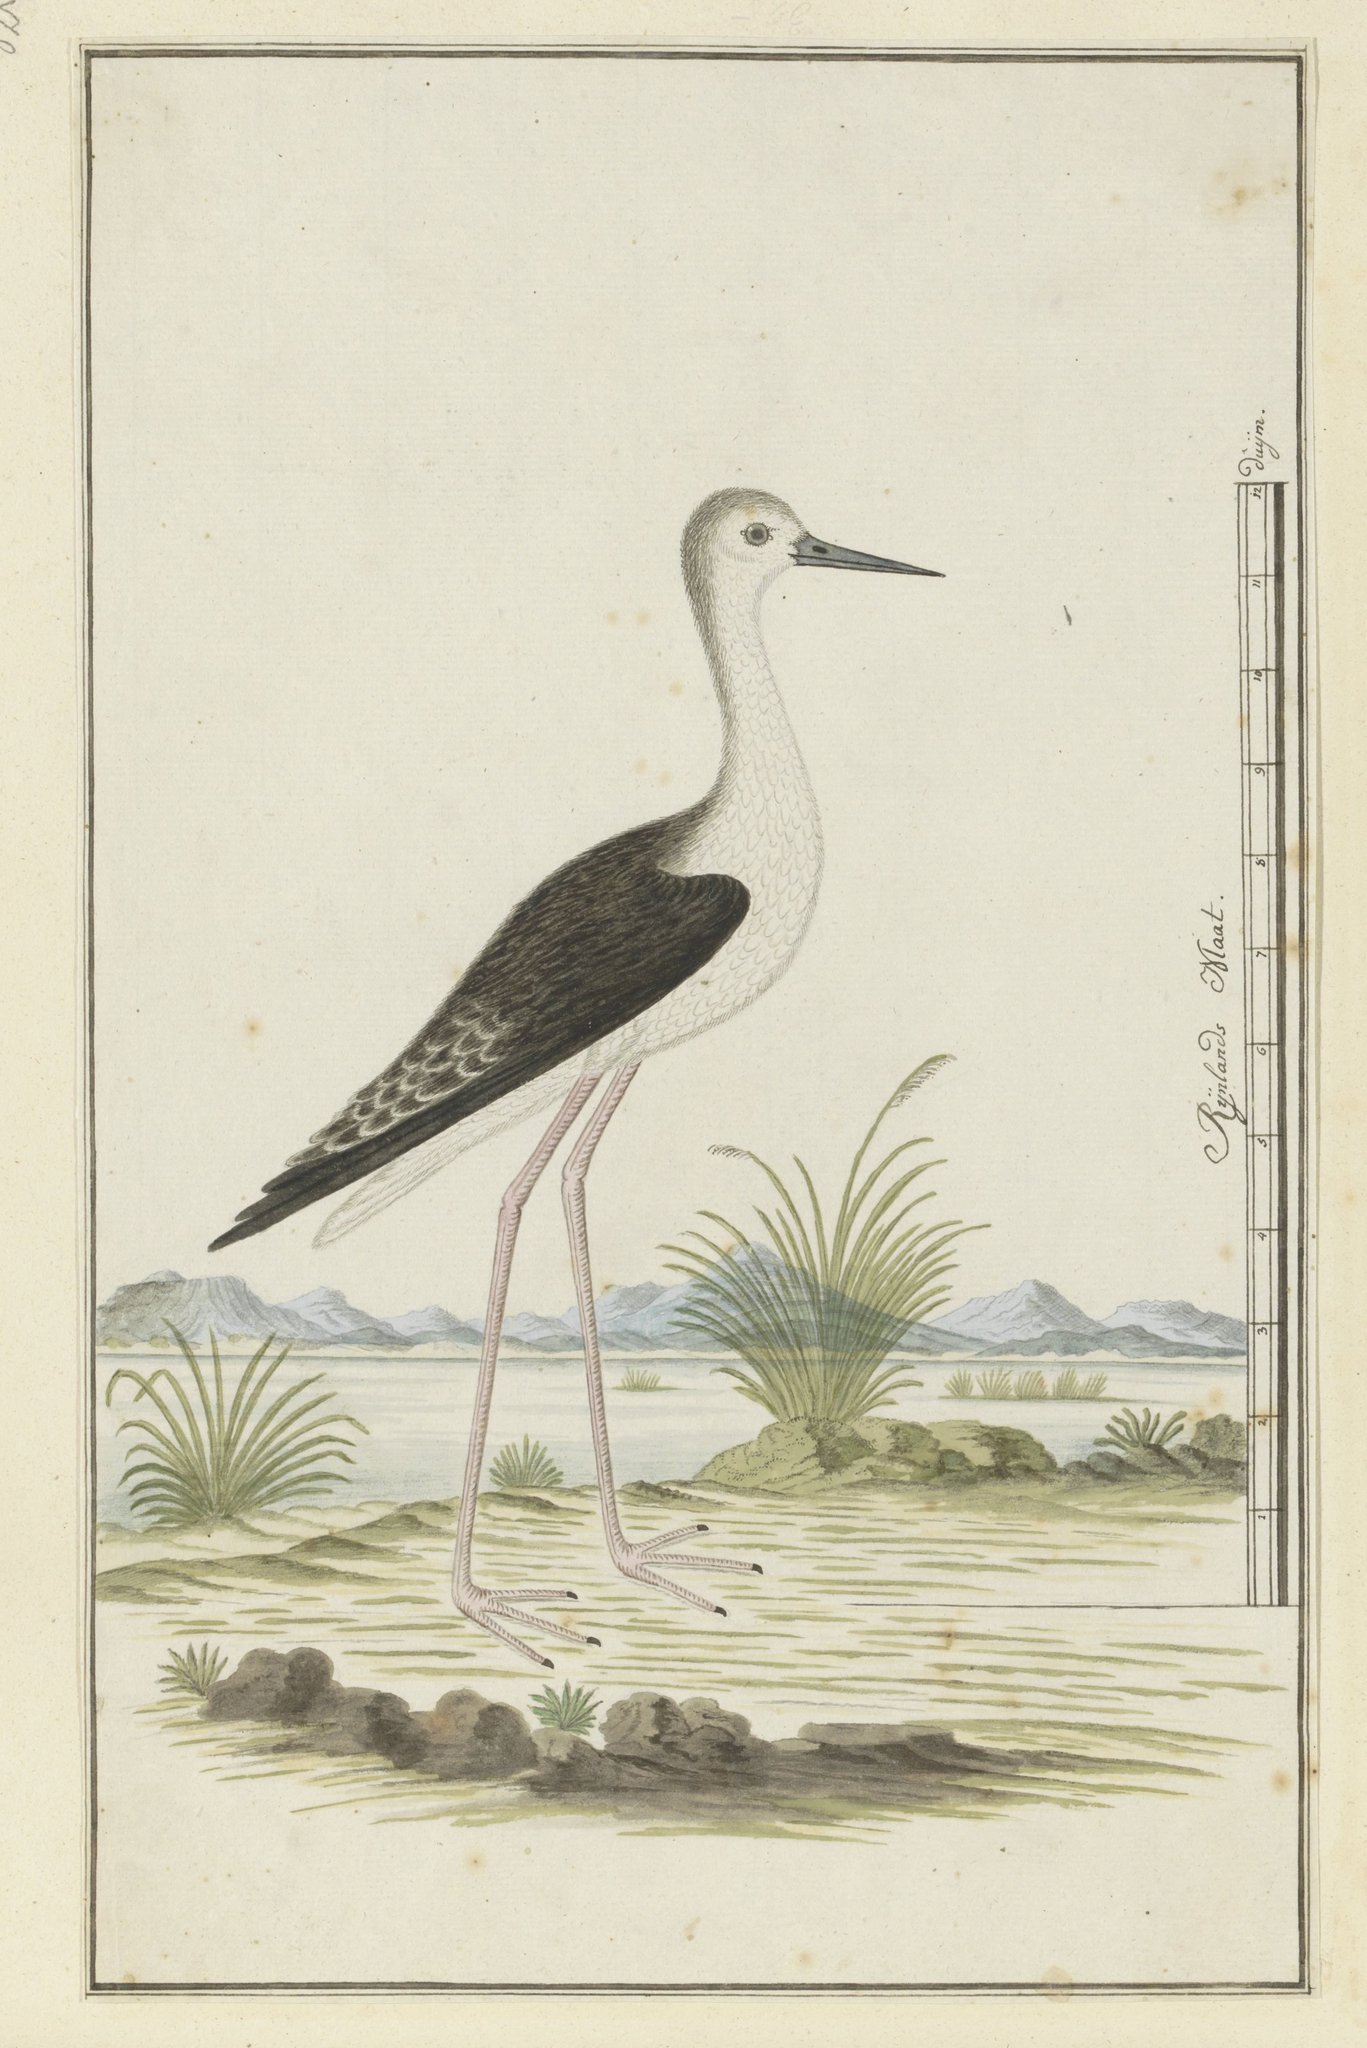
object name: drawing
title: Himantopus himantopus ? (Black-winged stilt)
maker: robert jacob gordon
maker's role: draughtsman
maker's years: 1743-1795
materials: chalk, ink, paper, pencil, watercolor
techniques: brush, pen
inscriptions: annotation: ‘schaalverdeling met: Rijnlands Maat; duijm’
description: Vogelstudie: Steltkluut (Himantopus himantopus); met schaalverdeling in Rijnlandse maat.